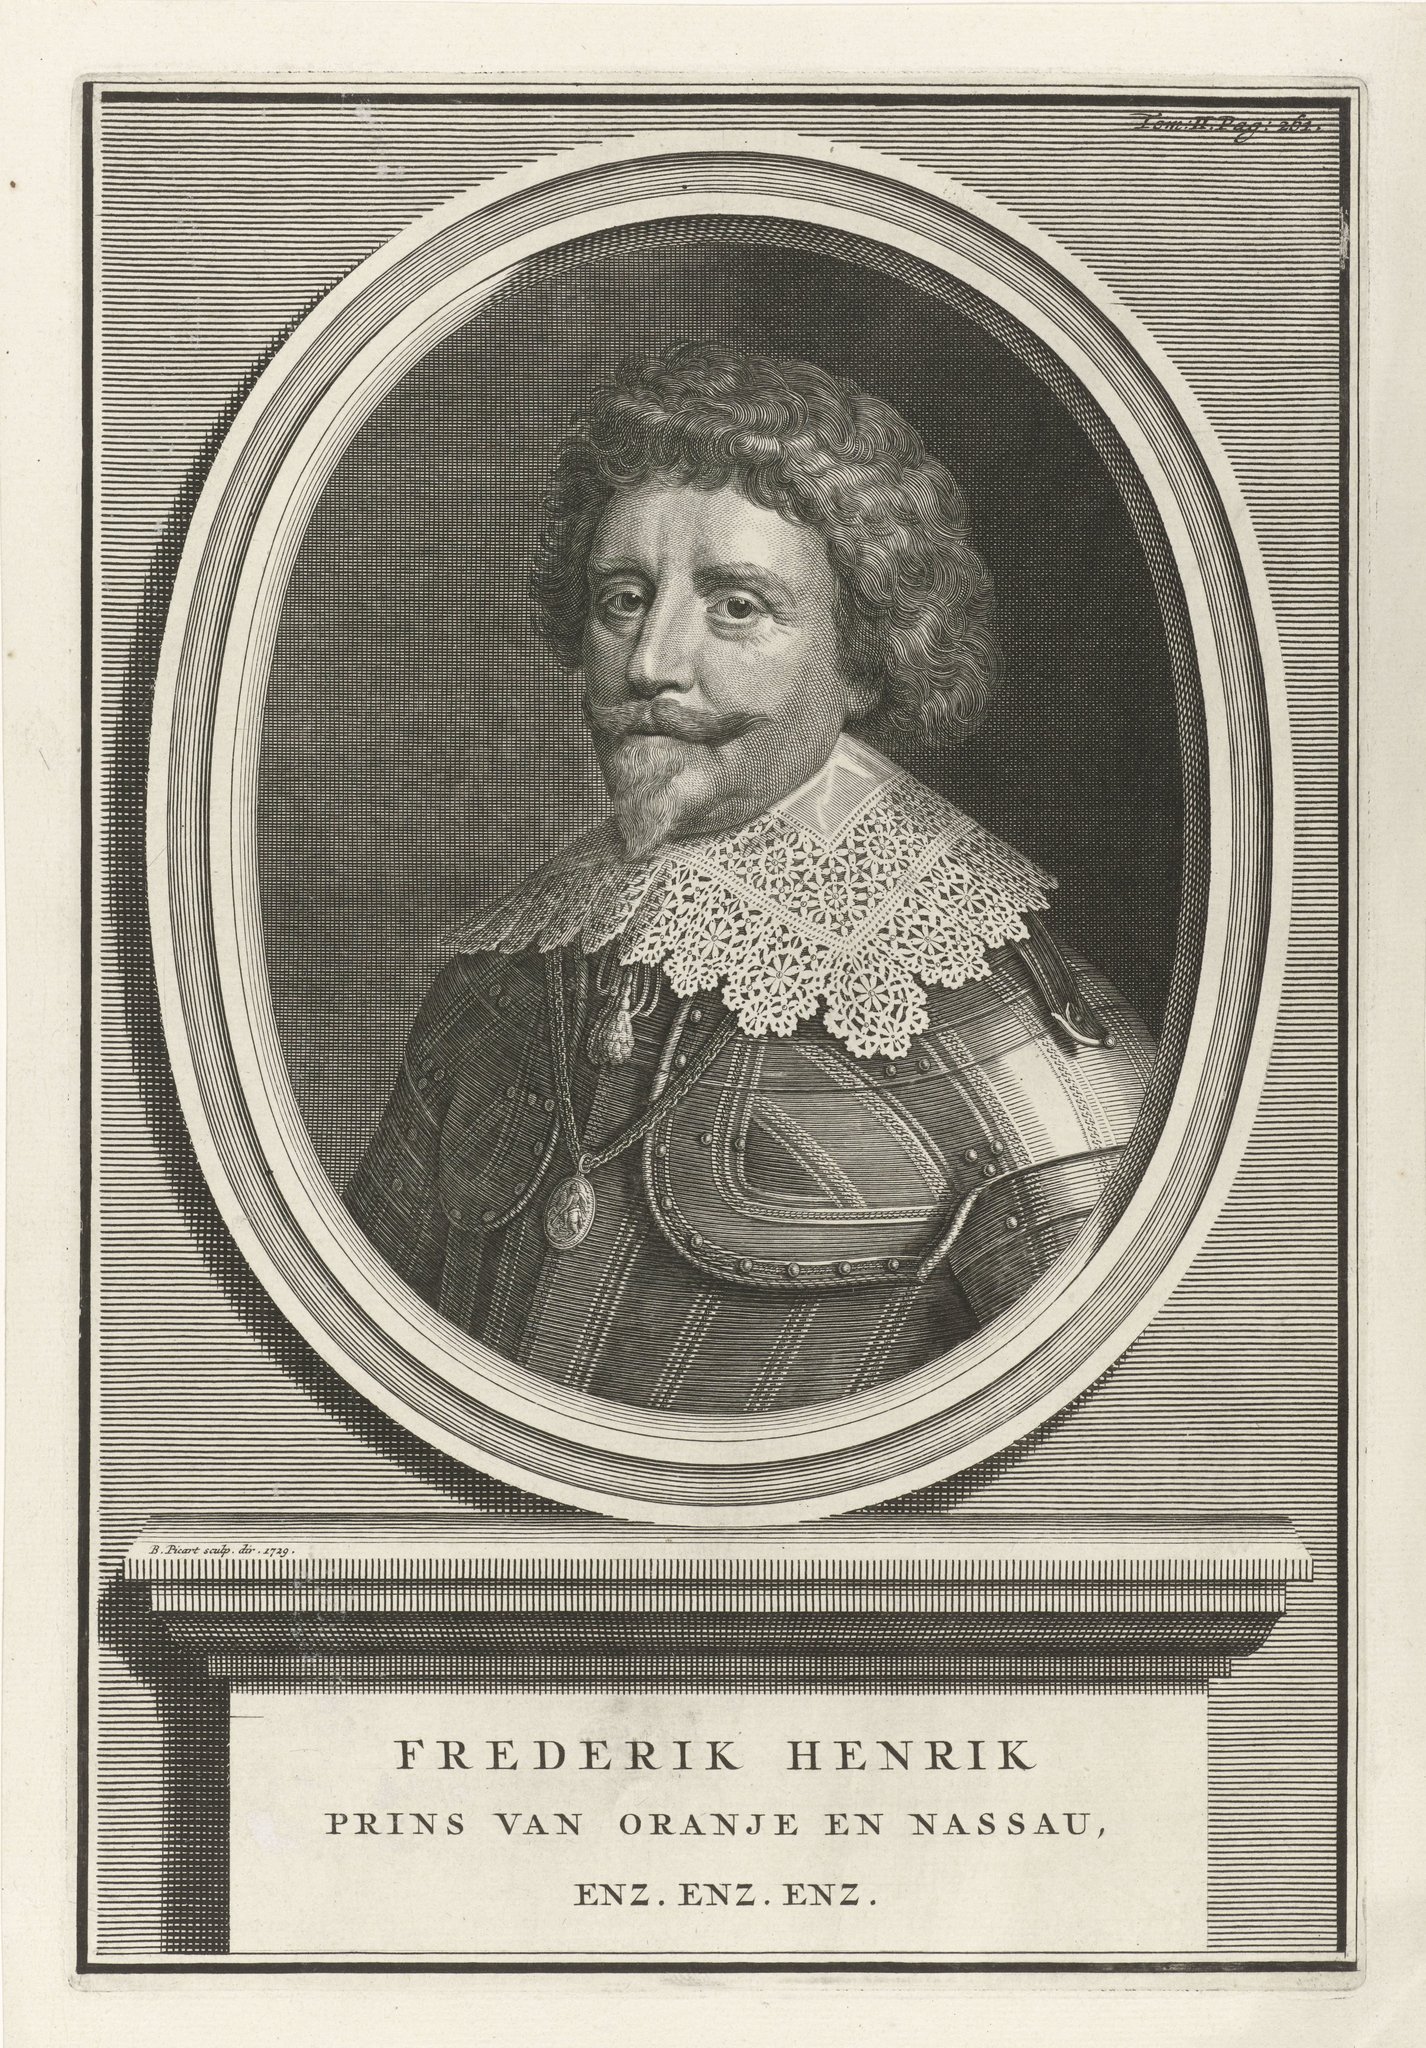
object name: print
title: Portret van Frederik Hendrik, prins van Oranje-Nassau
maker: bernard picart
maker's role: draughtsman, print maker, publisher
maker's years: 1673-1733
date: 1729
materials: paper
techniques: engraving, etching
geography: amsterdam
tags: the hague, frederick henry (prince of orange), armour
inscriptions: collector's mark: Lugt 2228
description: Prent als illustratie gebruikt in: Le Clerc, Jean. Geschiedenissen der Vereenigde Nederlanden. Amsterdam: Zacharias Chatelain (II), 1730.